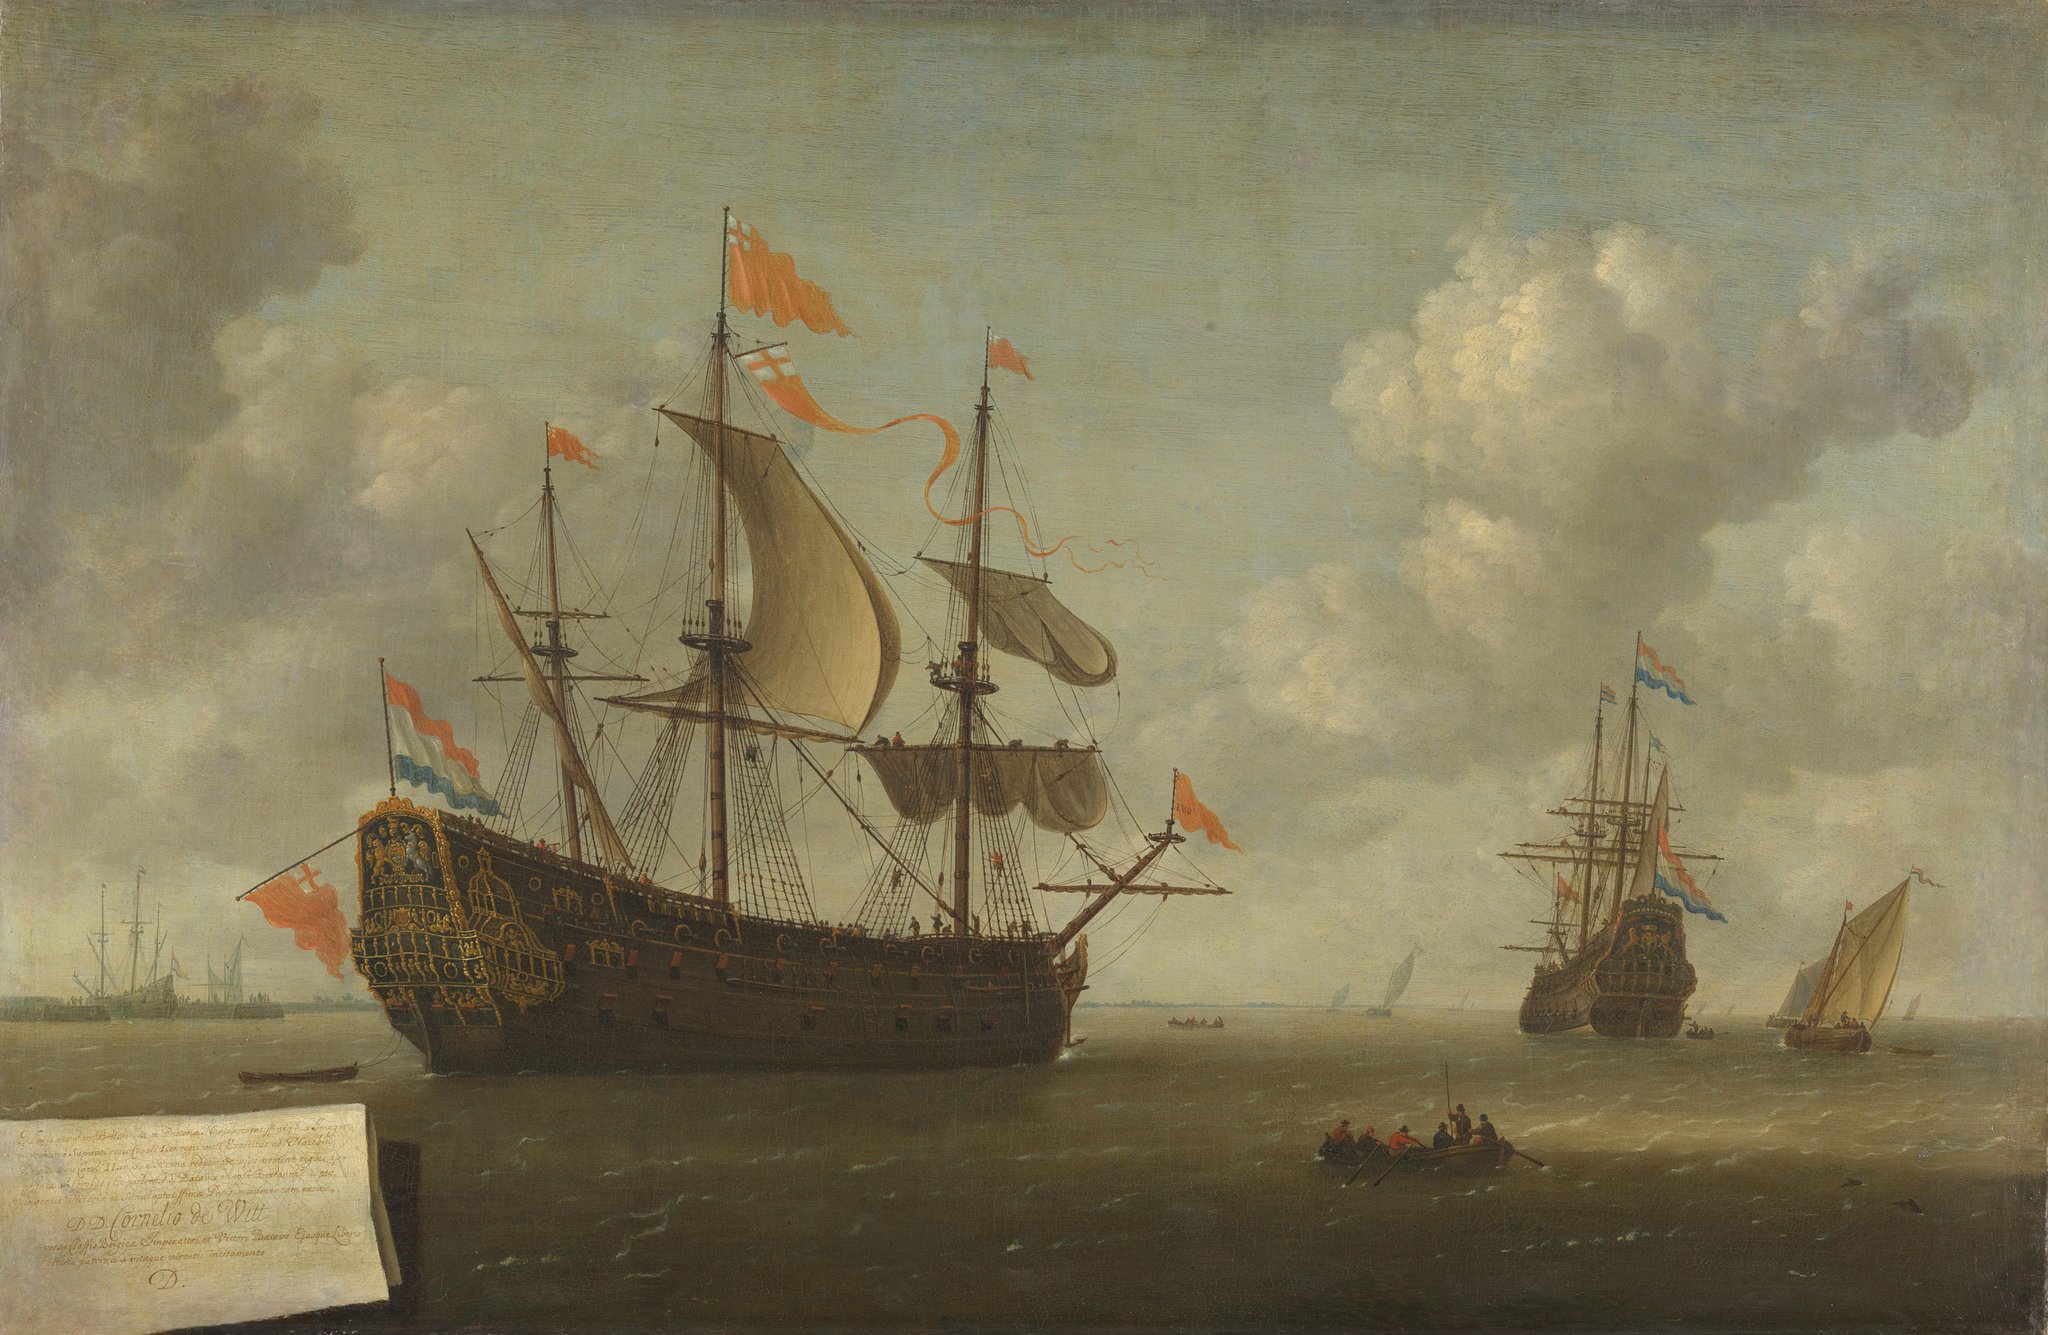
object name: painting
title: The Arrival of the Royal Charles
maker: jeronymus van diest (ii)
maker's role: painter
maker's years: 1631-1677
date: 1667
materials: canvas, oil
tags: sailing-ship, sailing-boat, navy, booty, spoil, hellevoetsluis, raid on the medway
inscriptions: inscription: ‘Huius quondam Britannicae et Praetoriae Navis accuratissime picta Imago: ... [pri]mo Superati regis Caroli I. et regii victi Exercitus ad Nazebin: Deinde regis Caroli II. is sua Regna reducis: de cujus nomine regius appellata a Carolus: Et postremo a Batavis in ipsa Britannia capta ingentis Victoriae et simul optatissimae Pacis monimentum extitit D.D. Cornelio de Witt versae Classis Belgicae Imperatori et Victori Batavo: Ejusque Liberis Posteris paternae avitaeque virtutis incitamento D.’, signature: ‘I.V.D.’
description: The Royal Charles was the most powerful warship in the English fleet. The Dutch captured the vessel during the raid on the naval base at Chatham in June 1667 and moved it to the Dutch port of Hellevoetsluis. The English ship’s flag is lowered to signify its surrender. The ship’s ornamentally carved counter is on display in this gallery.